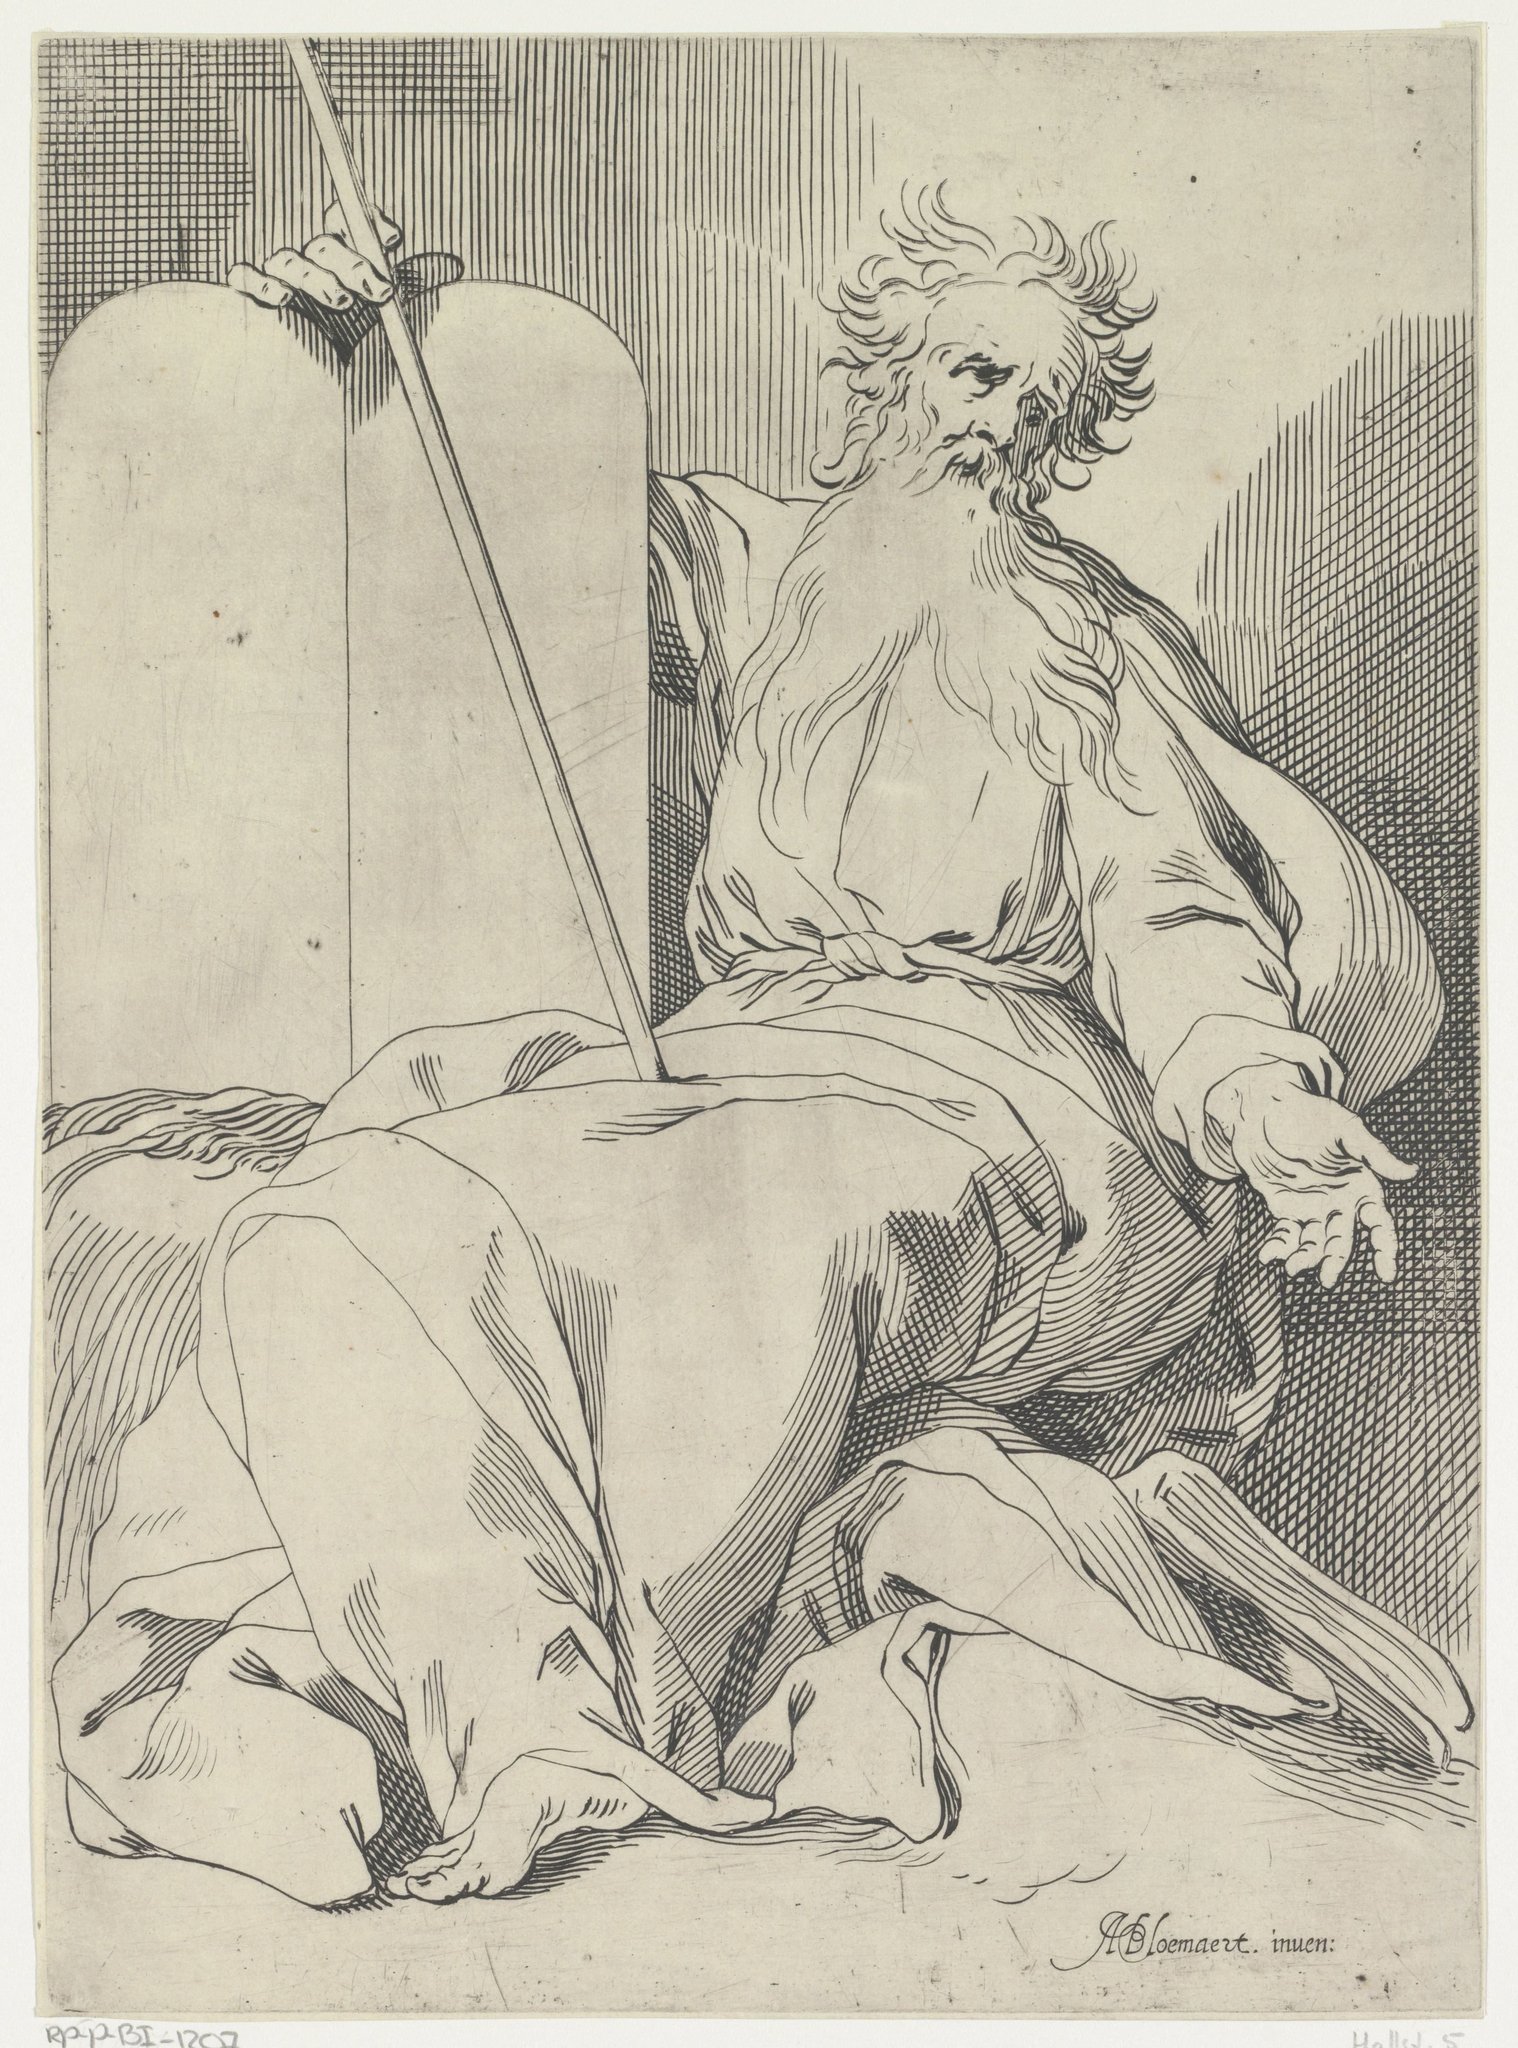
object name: print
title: Mozes met de tafelen der wet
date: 1610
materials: paper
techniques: etching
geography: netherlands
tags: moses (not in biblical context); possible attributes: rays of light or horns on his head, rod, tables of the law, the ten commandments represented together on stone tablets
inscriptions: collector's mark: Lugt 240